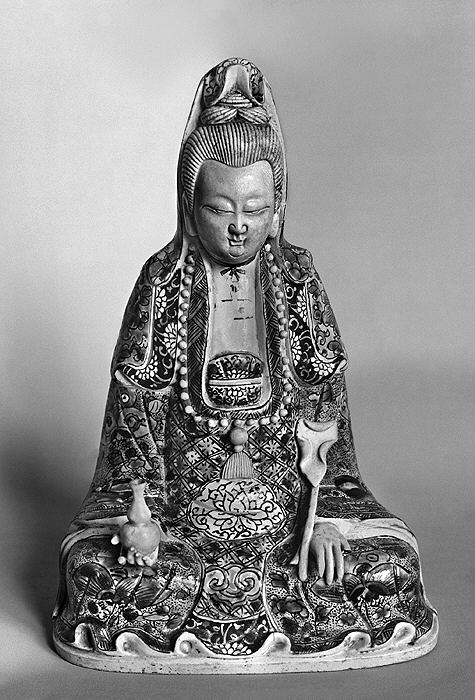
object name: figure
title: Figure of bodhisattva Guanyin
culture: chinese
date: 1801-1900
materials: enamel, porcelain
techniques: overglaze, painting, polychrome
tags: bodhisattvas